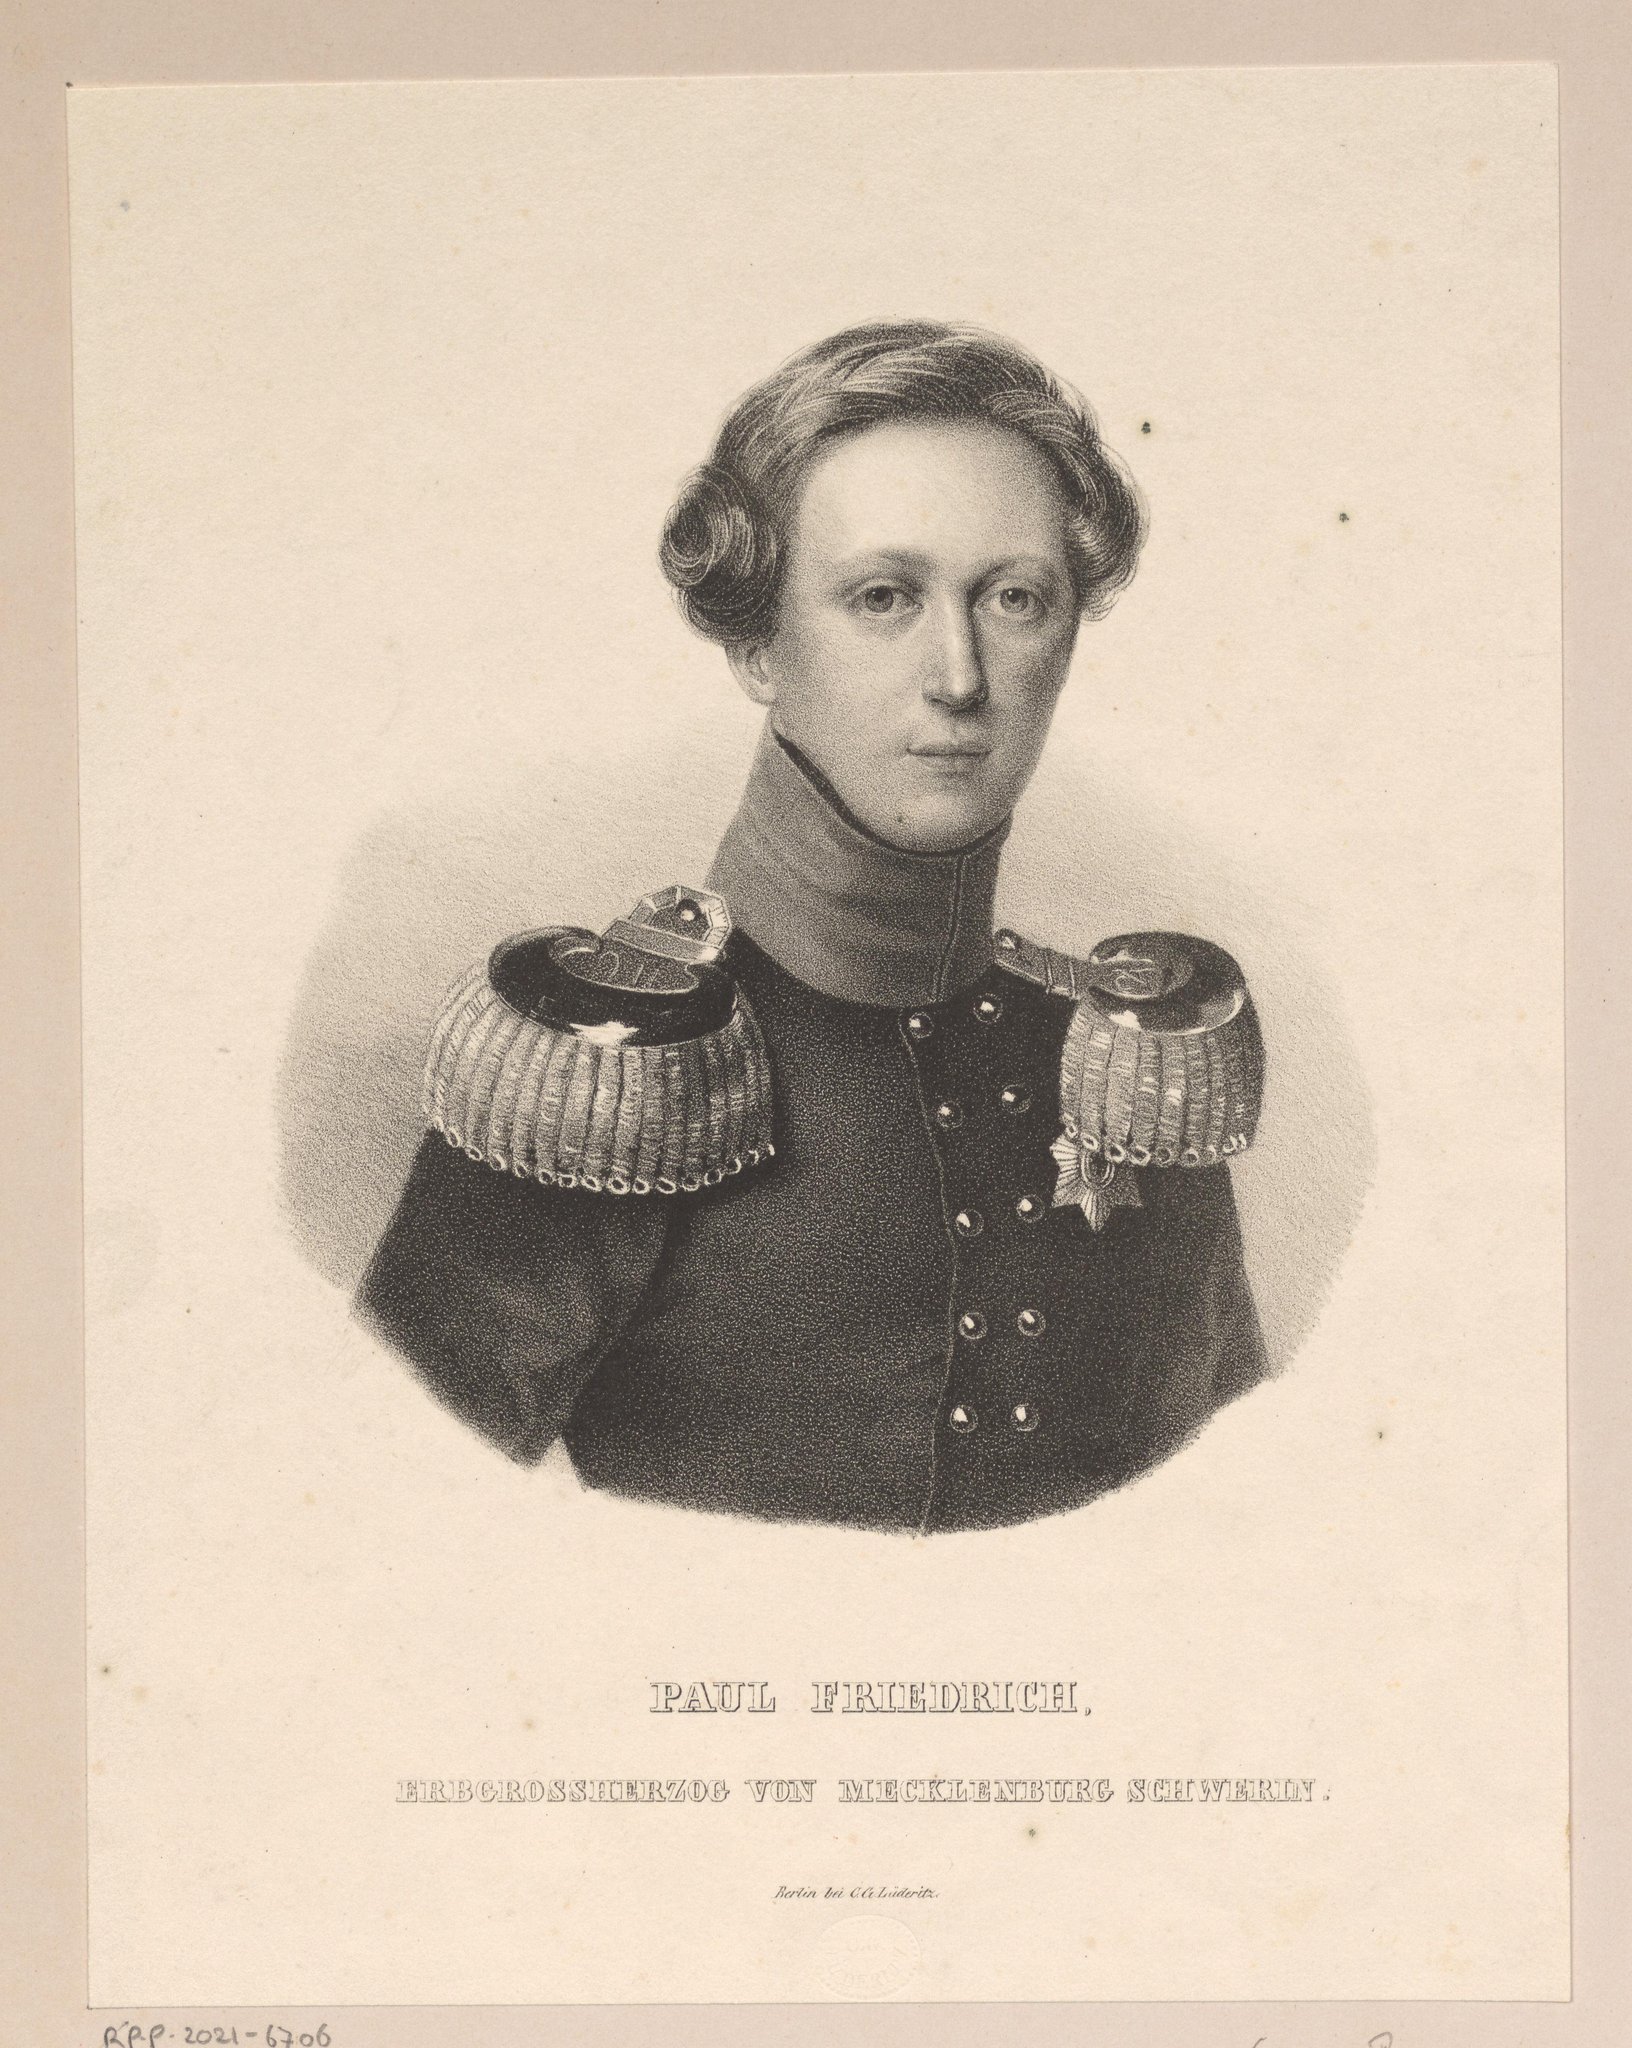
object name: print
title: Portret van Paul Friedrich van Mecklenburg-Schwerin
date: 1819-1837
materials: paper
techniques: lithograph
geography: berlin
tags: adult man, historical persons, (military) uniforms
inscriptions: check stamp: Lugt 4519